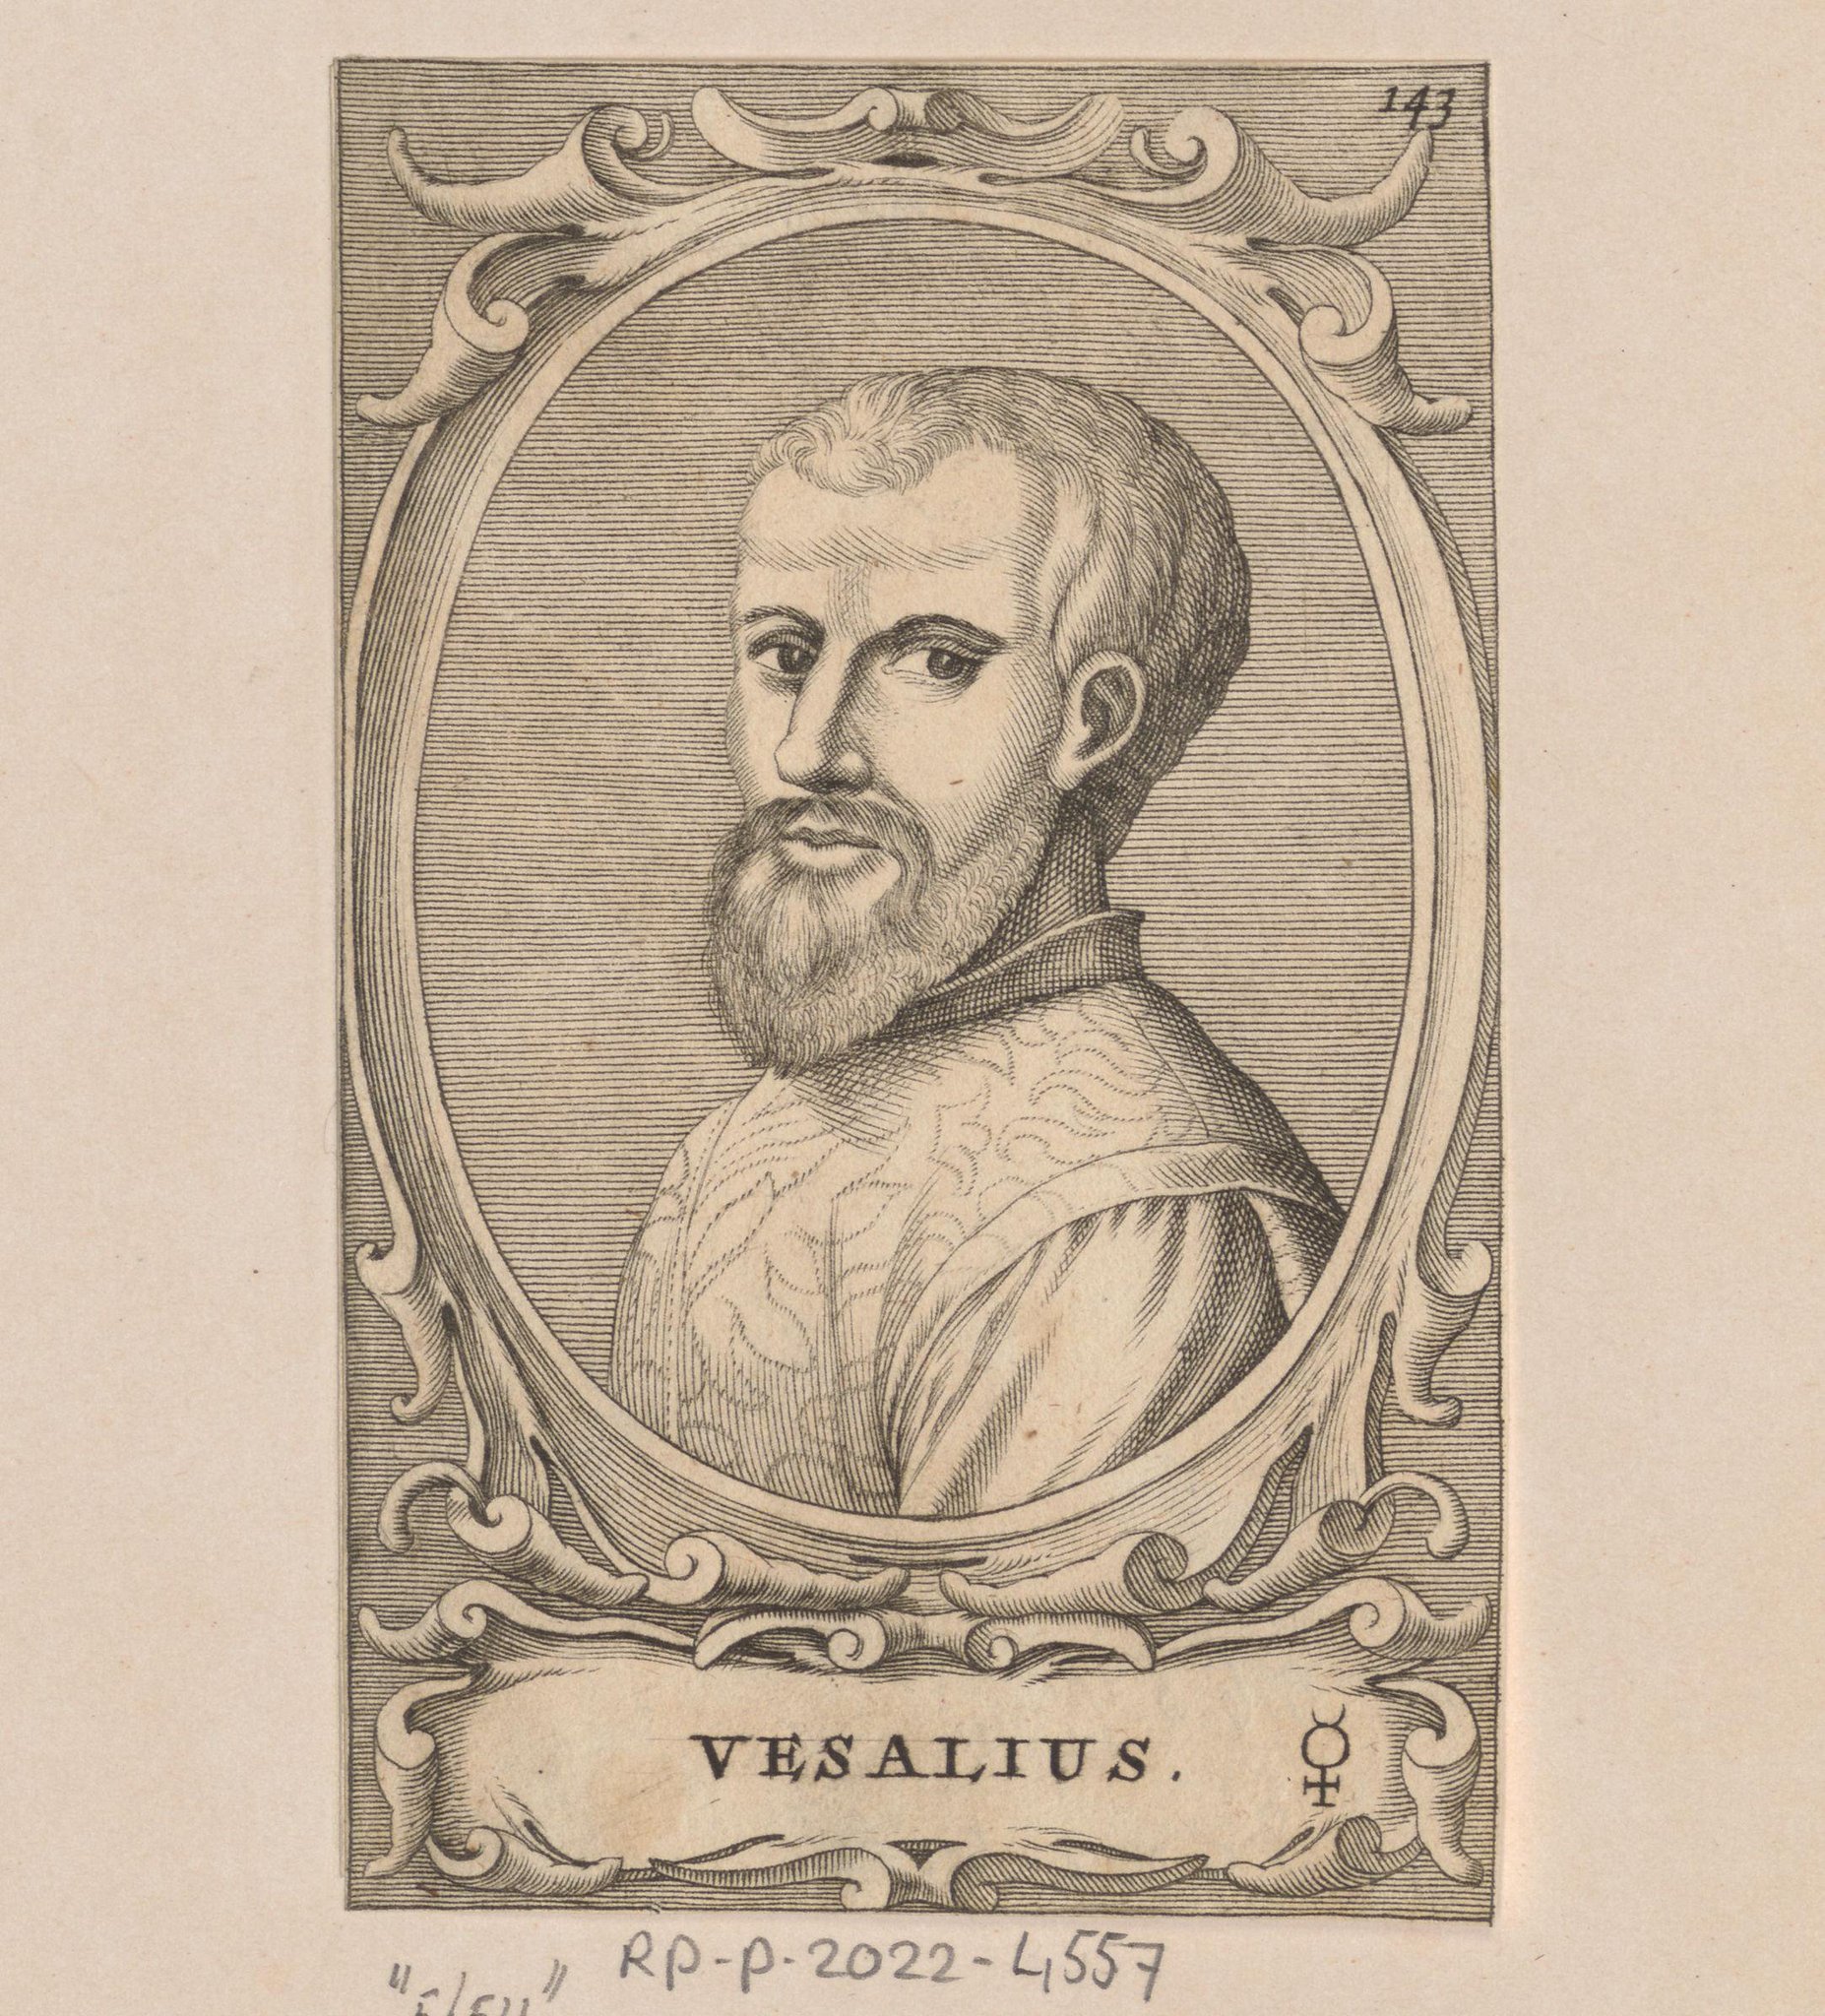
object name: print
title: Portret van Andreas Vesalius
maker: Anonymous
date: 1676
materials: paper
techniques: engraving, etching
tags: brussels, scholar, philosopher, historical persons, physician, doctor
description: Prent waarschijnlijk uit: Helvétius, Johann Friedrich. Microscopium physiognomiae medicum (..). Amsterdam: Janssonius Waesberge, 1676, p. 142-143.